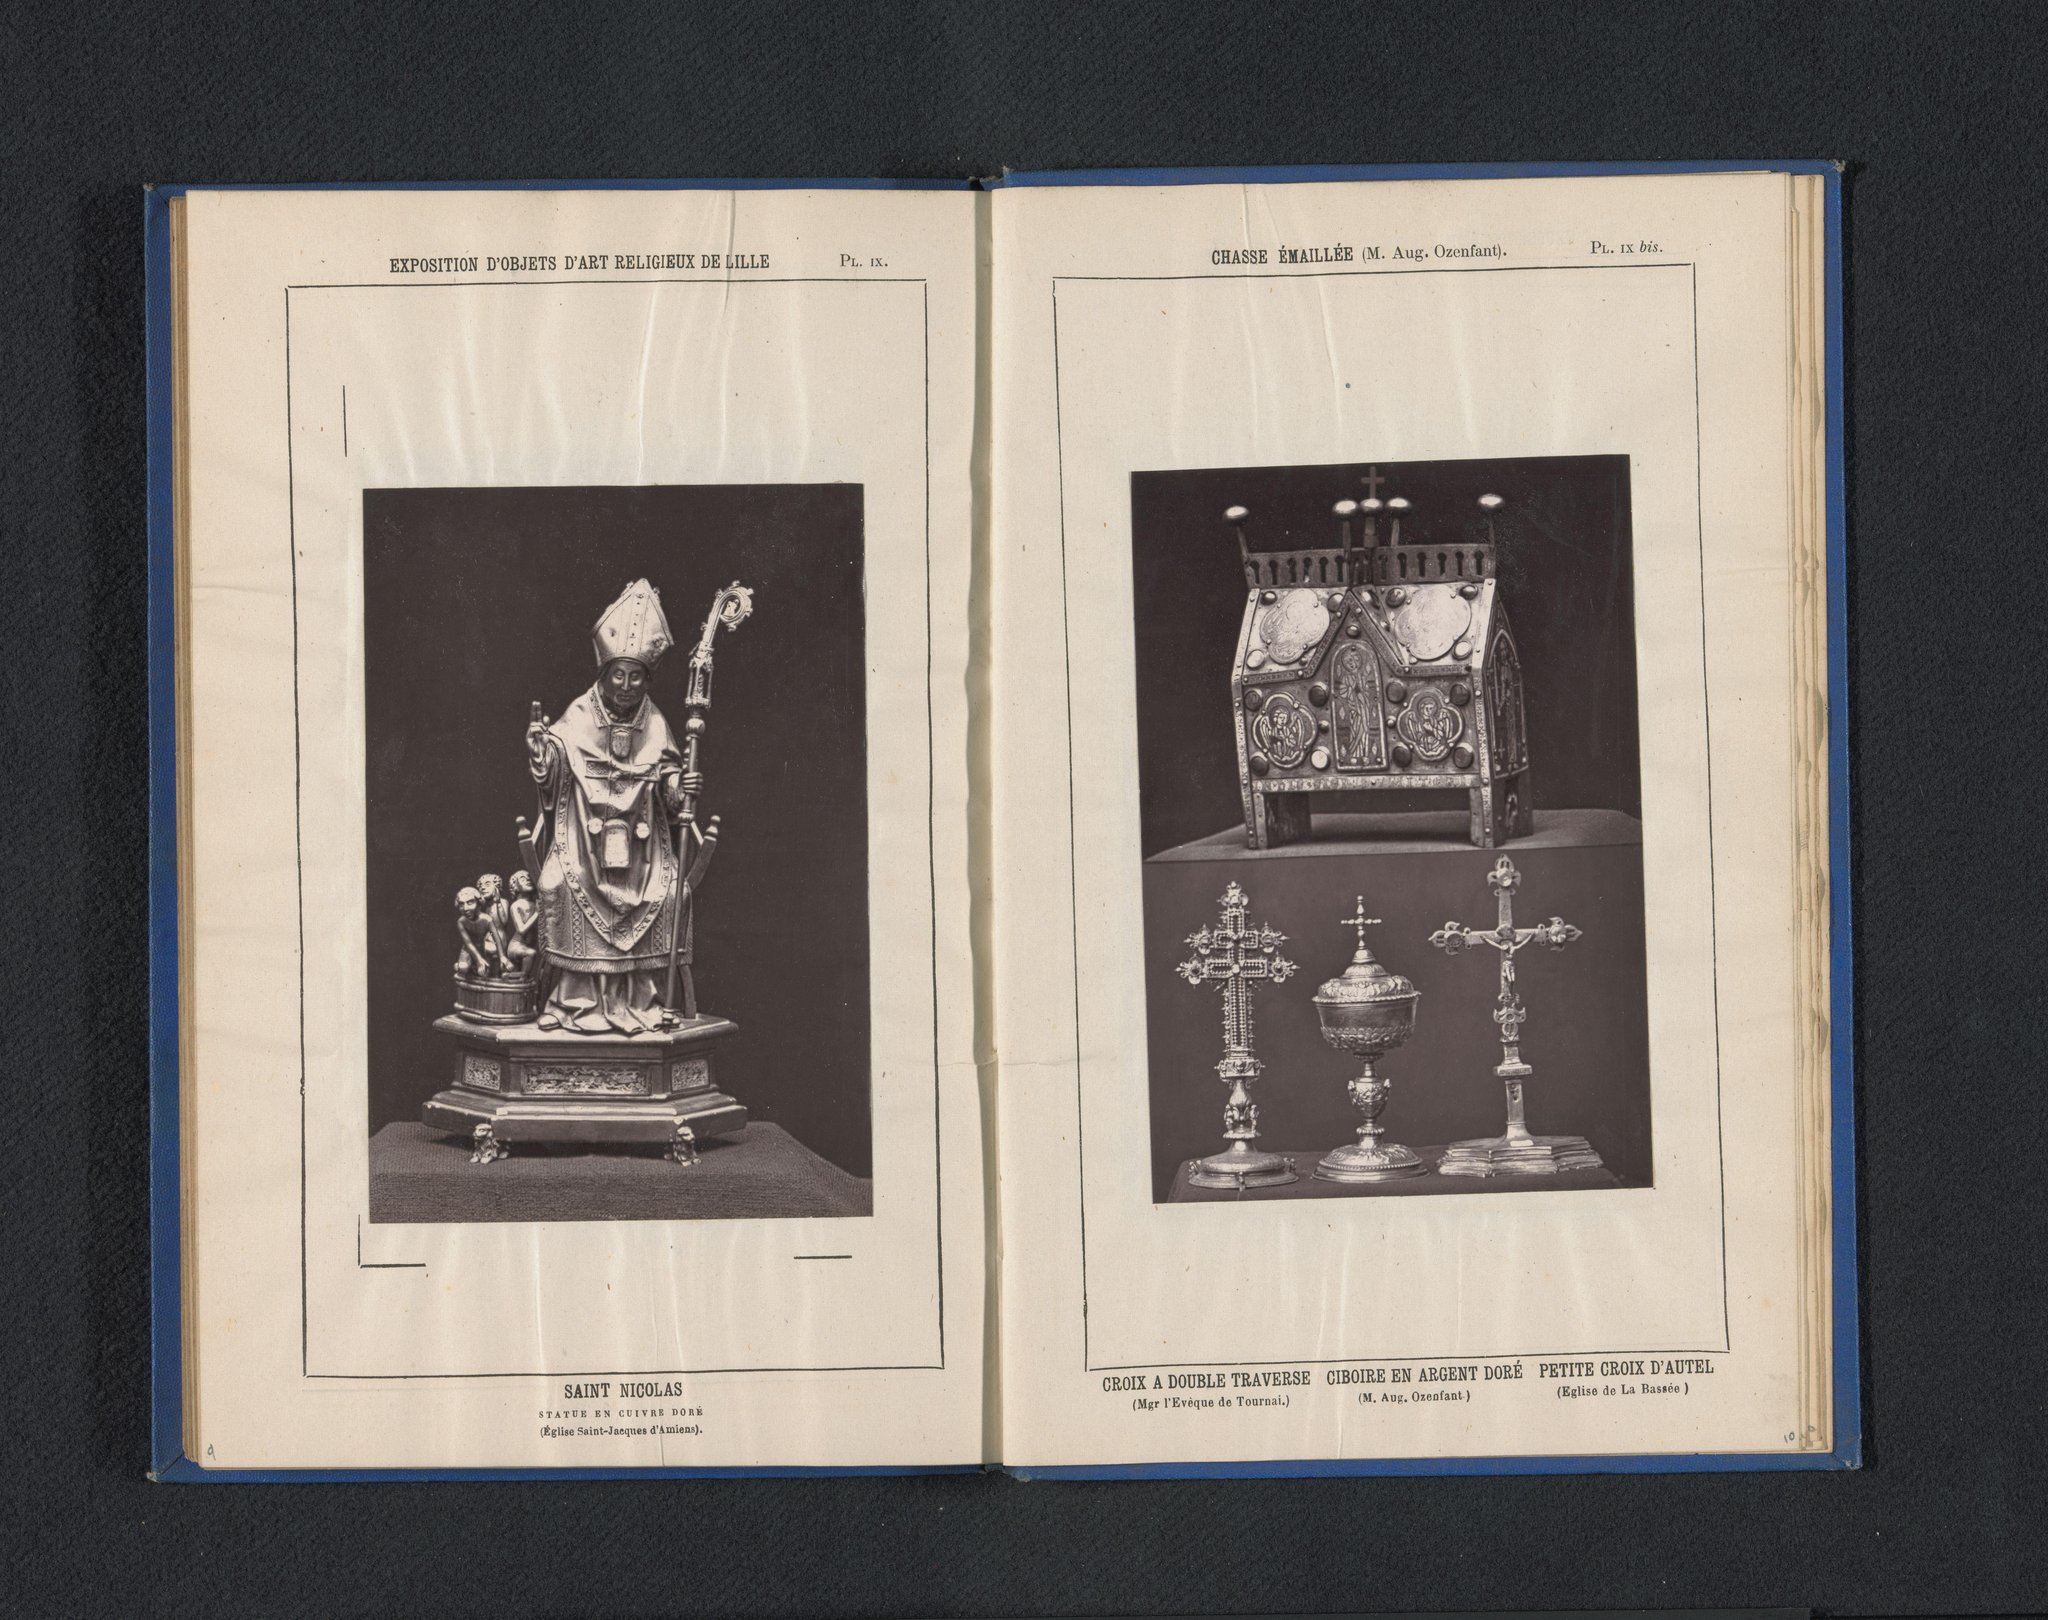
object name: photomechanical print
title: Saint Nicolas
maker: Anonymous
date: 1871-1876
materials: cardboard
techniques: woodburytype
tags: the bishop nicholas of myra (or bari); possible attributes: anchor, boat, three golden balls (on a book), three purses, three children in a tub, three maidens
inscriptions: inscription: ‘Statue en cuive doré/ (Église Saint-Jacques d'Amiens)’, inscription: ‘Exposition d'objets d'art religieux de Lille’, inscription: ‘Pl. IX.’